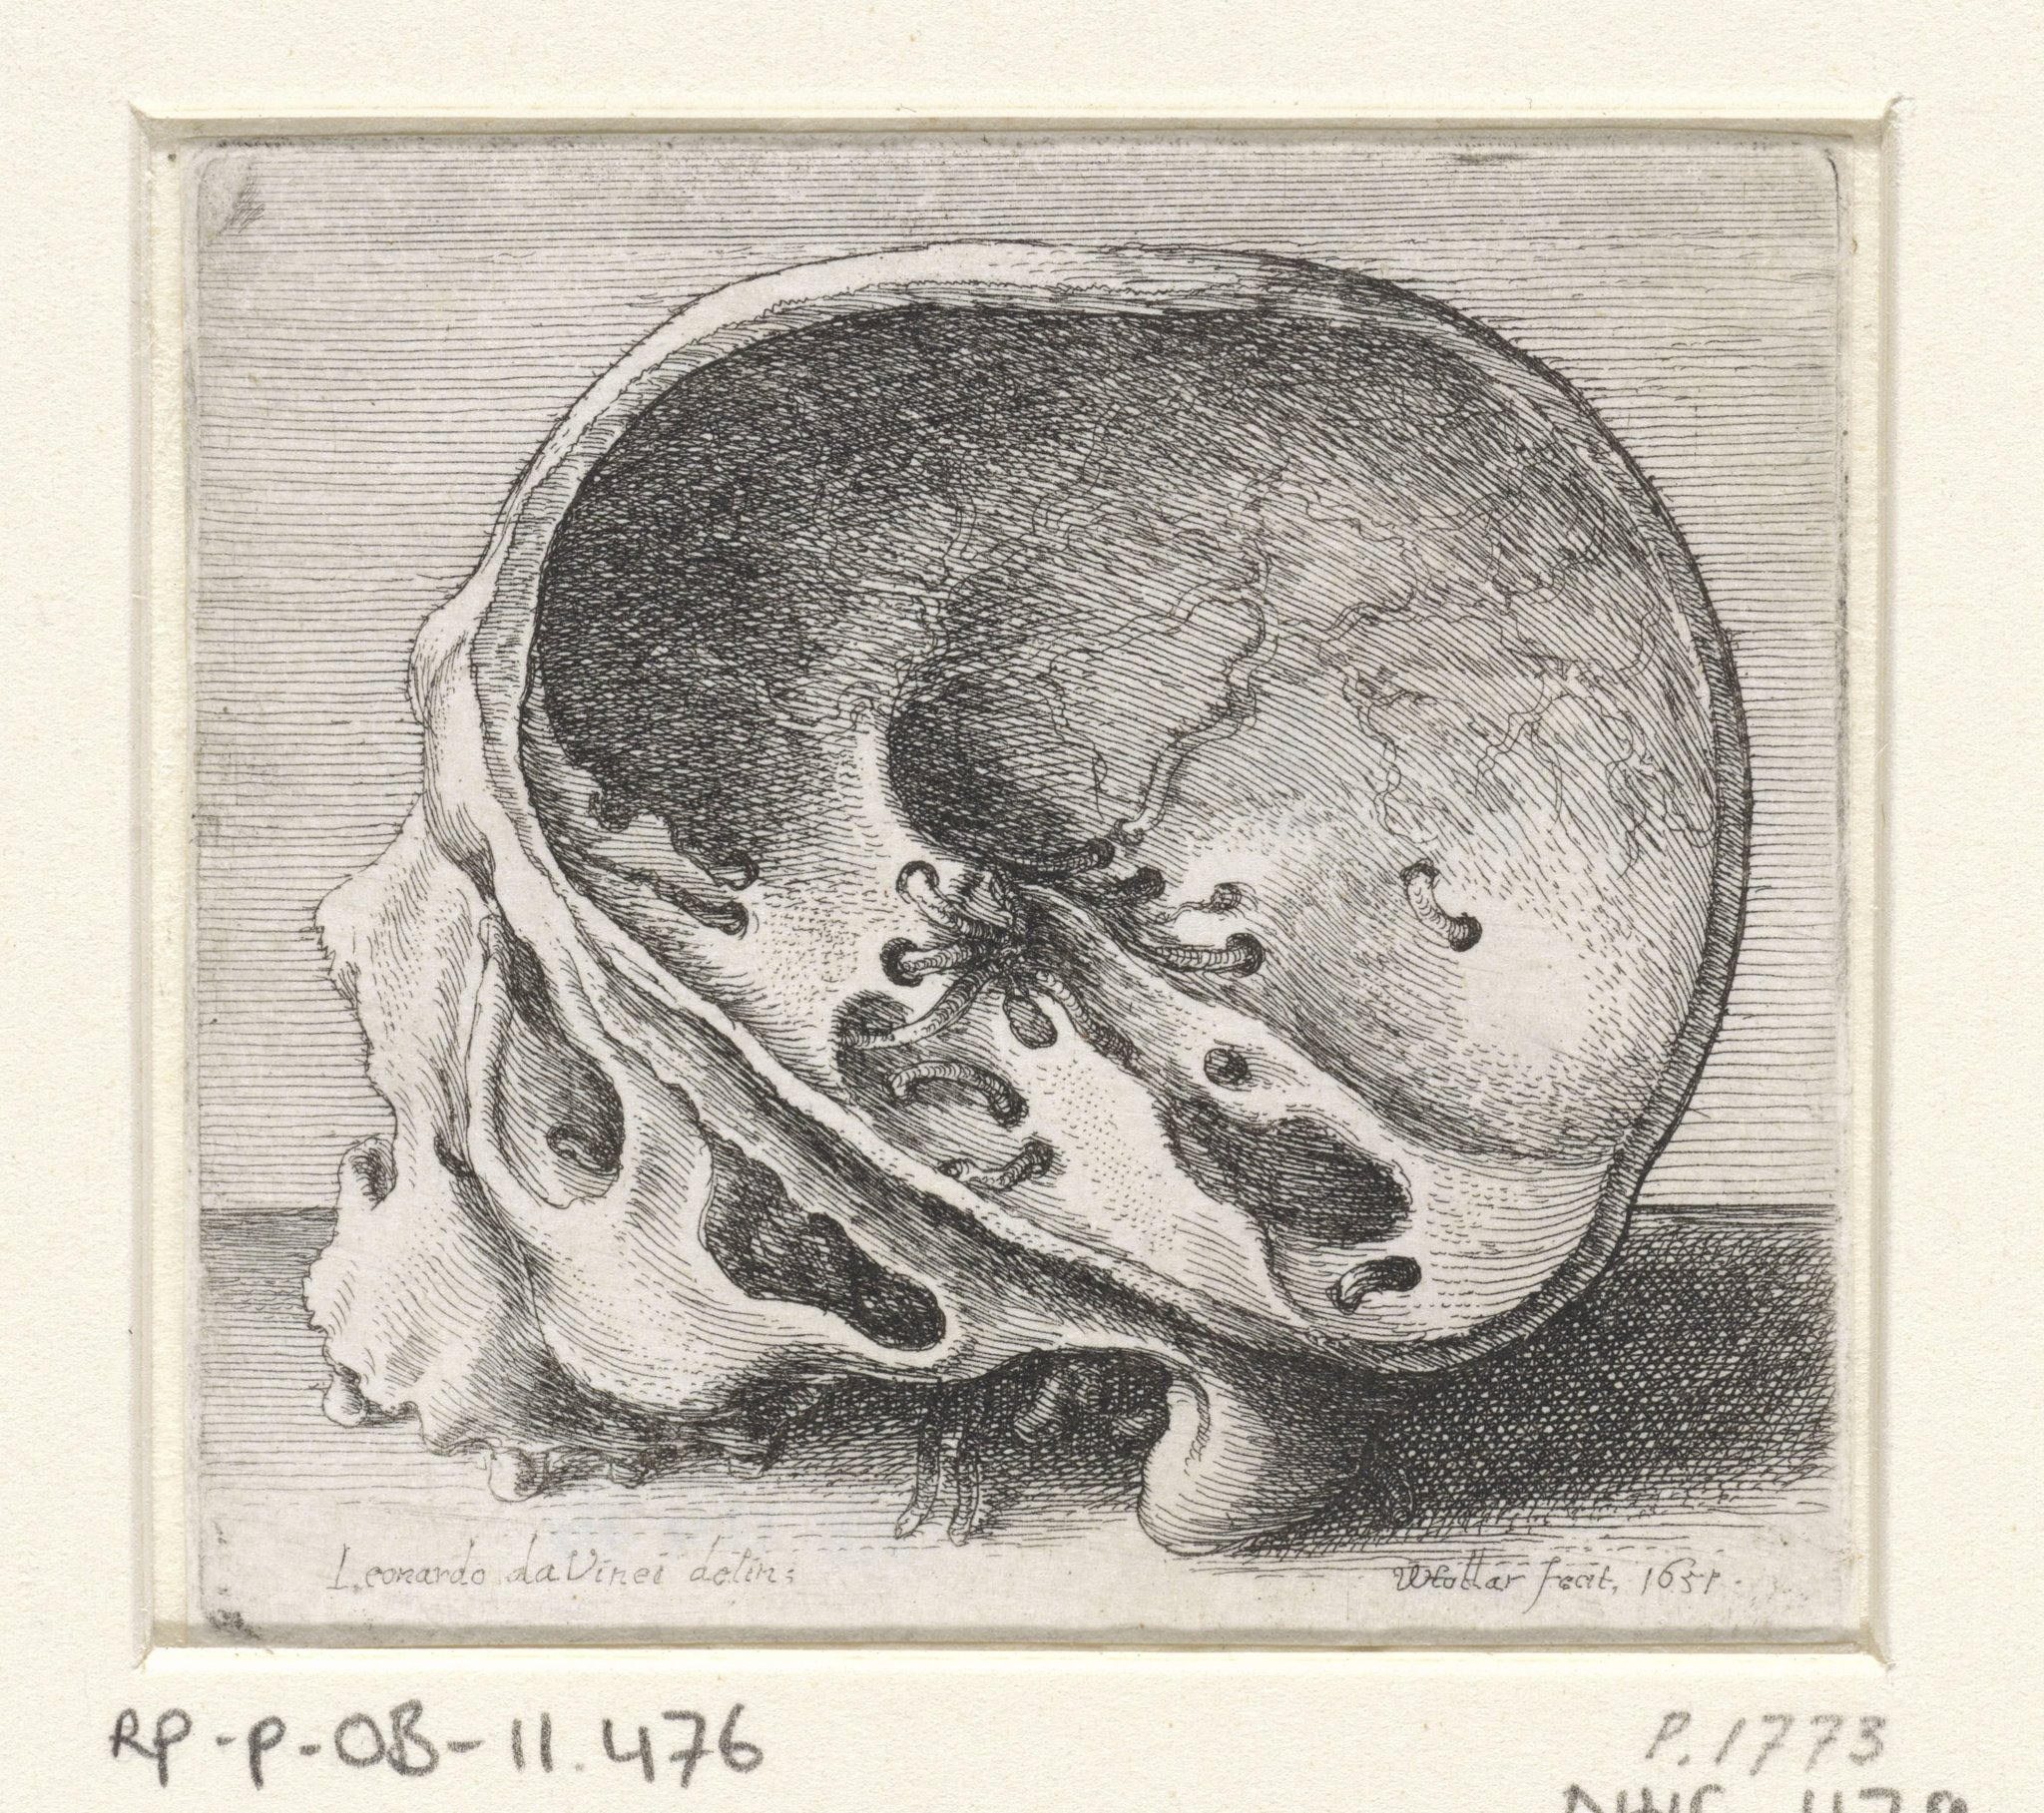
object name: print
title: Anatomische studie van een schedel met wormgaten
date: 1651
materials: paper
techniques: etching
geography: antwerp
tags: (human) skull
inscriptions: collector's mark: Lugt 240